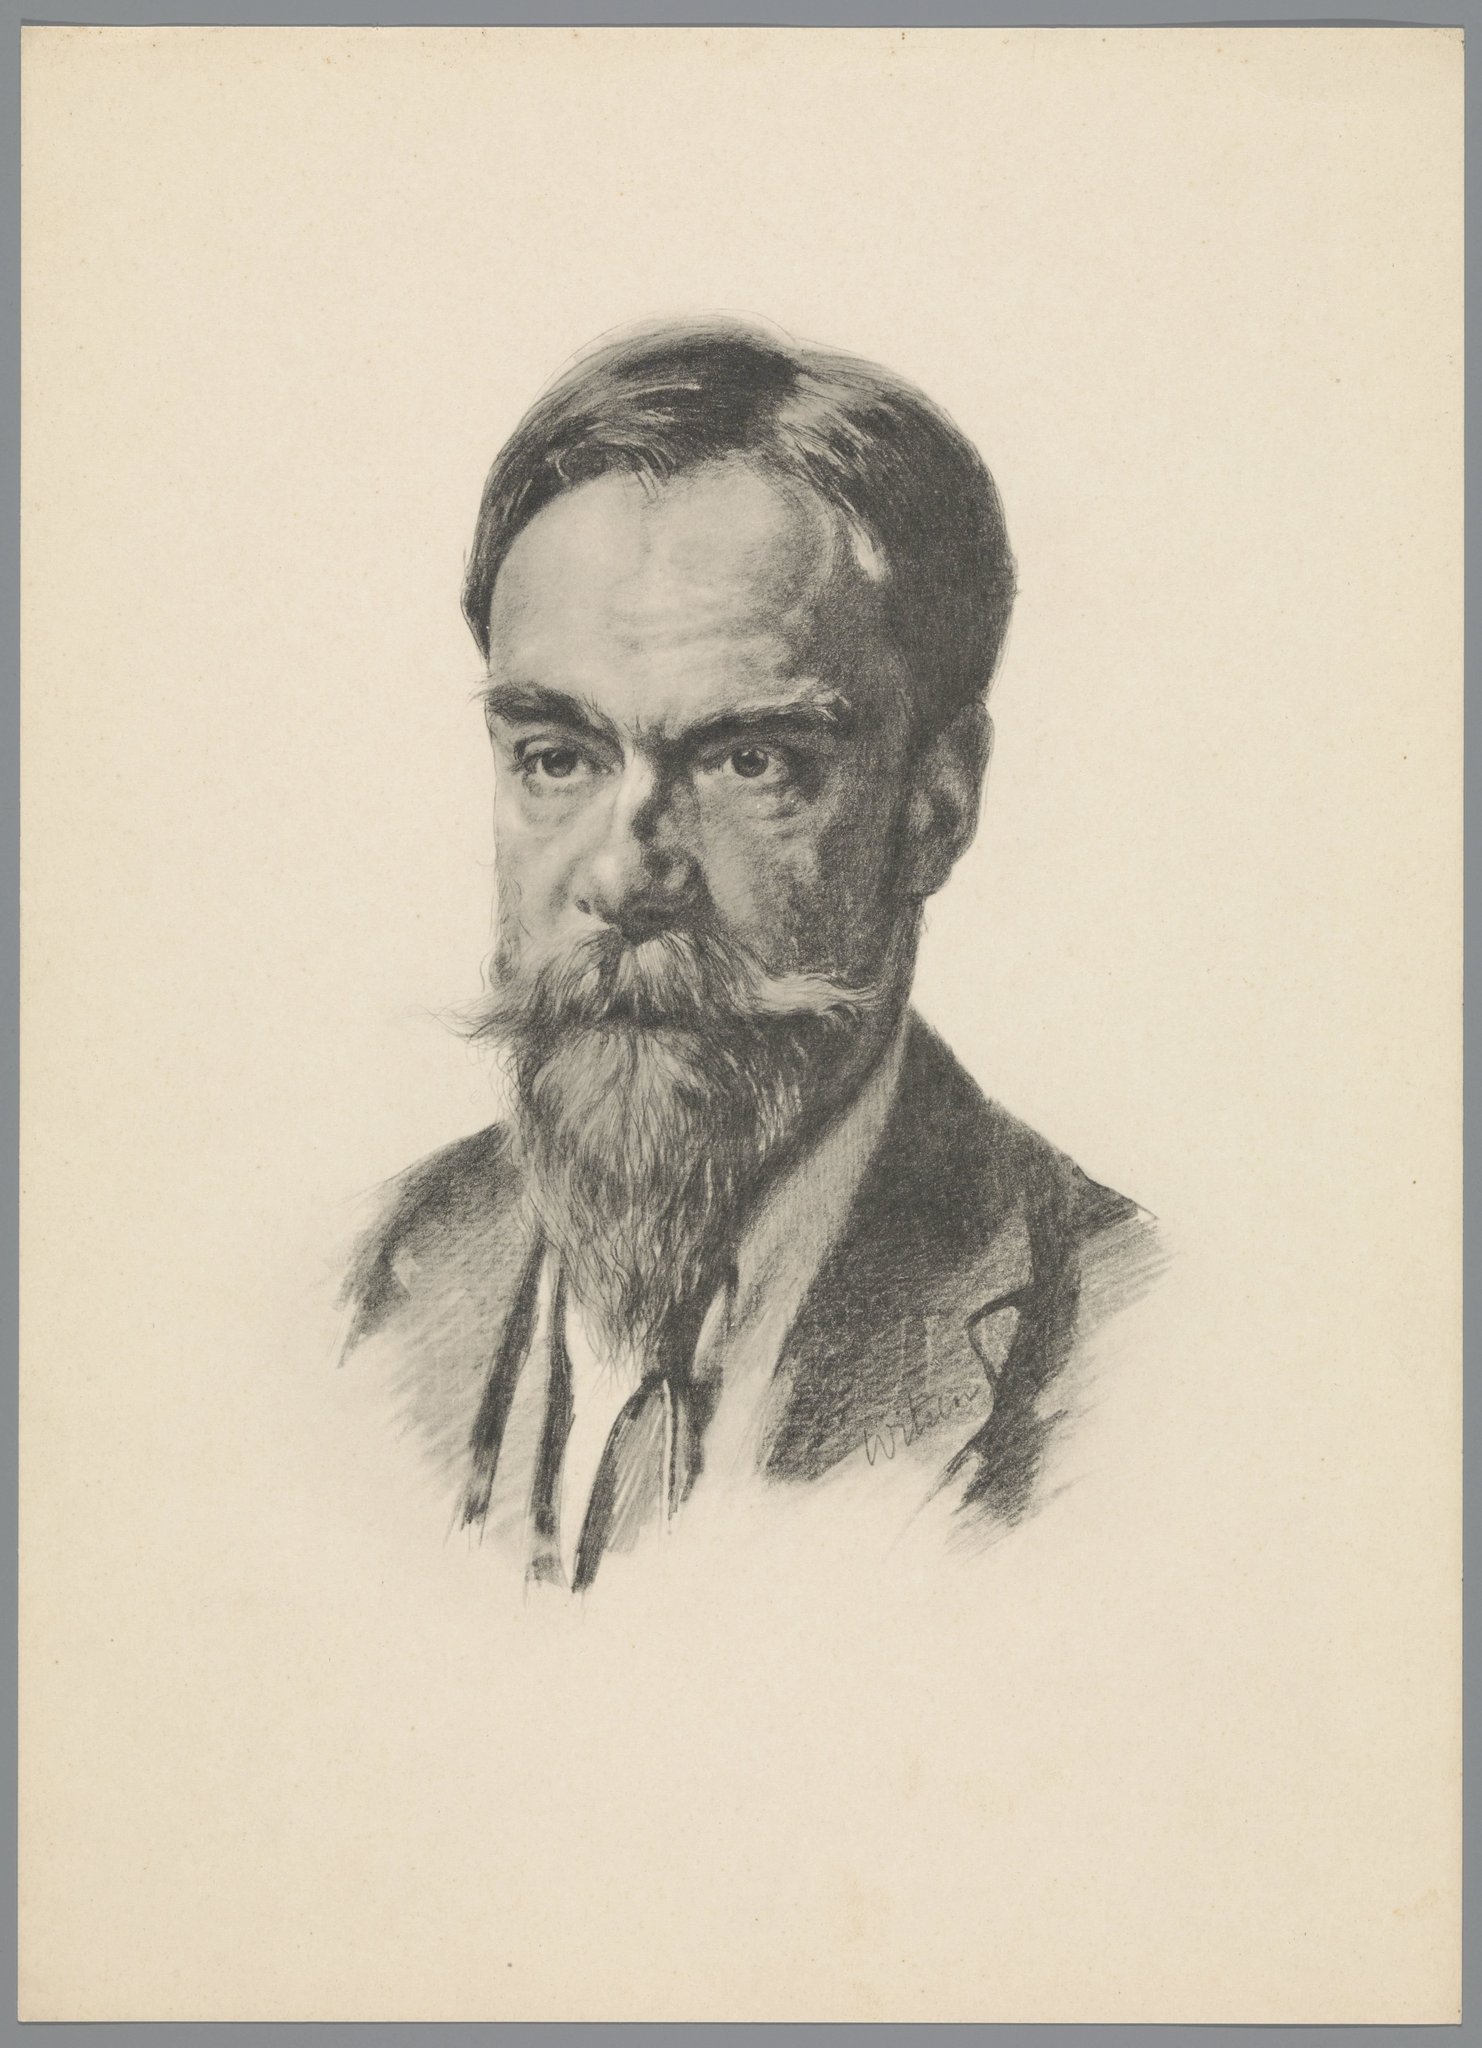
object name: print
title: Reproductie naar krijttekening met portret van Frans Coenen Jr.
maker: Anonymous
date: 1860-1915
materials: paper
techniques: photograph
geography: netherlands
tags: amsterdam, frans coenen (1866-1936)